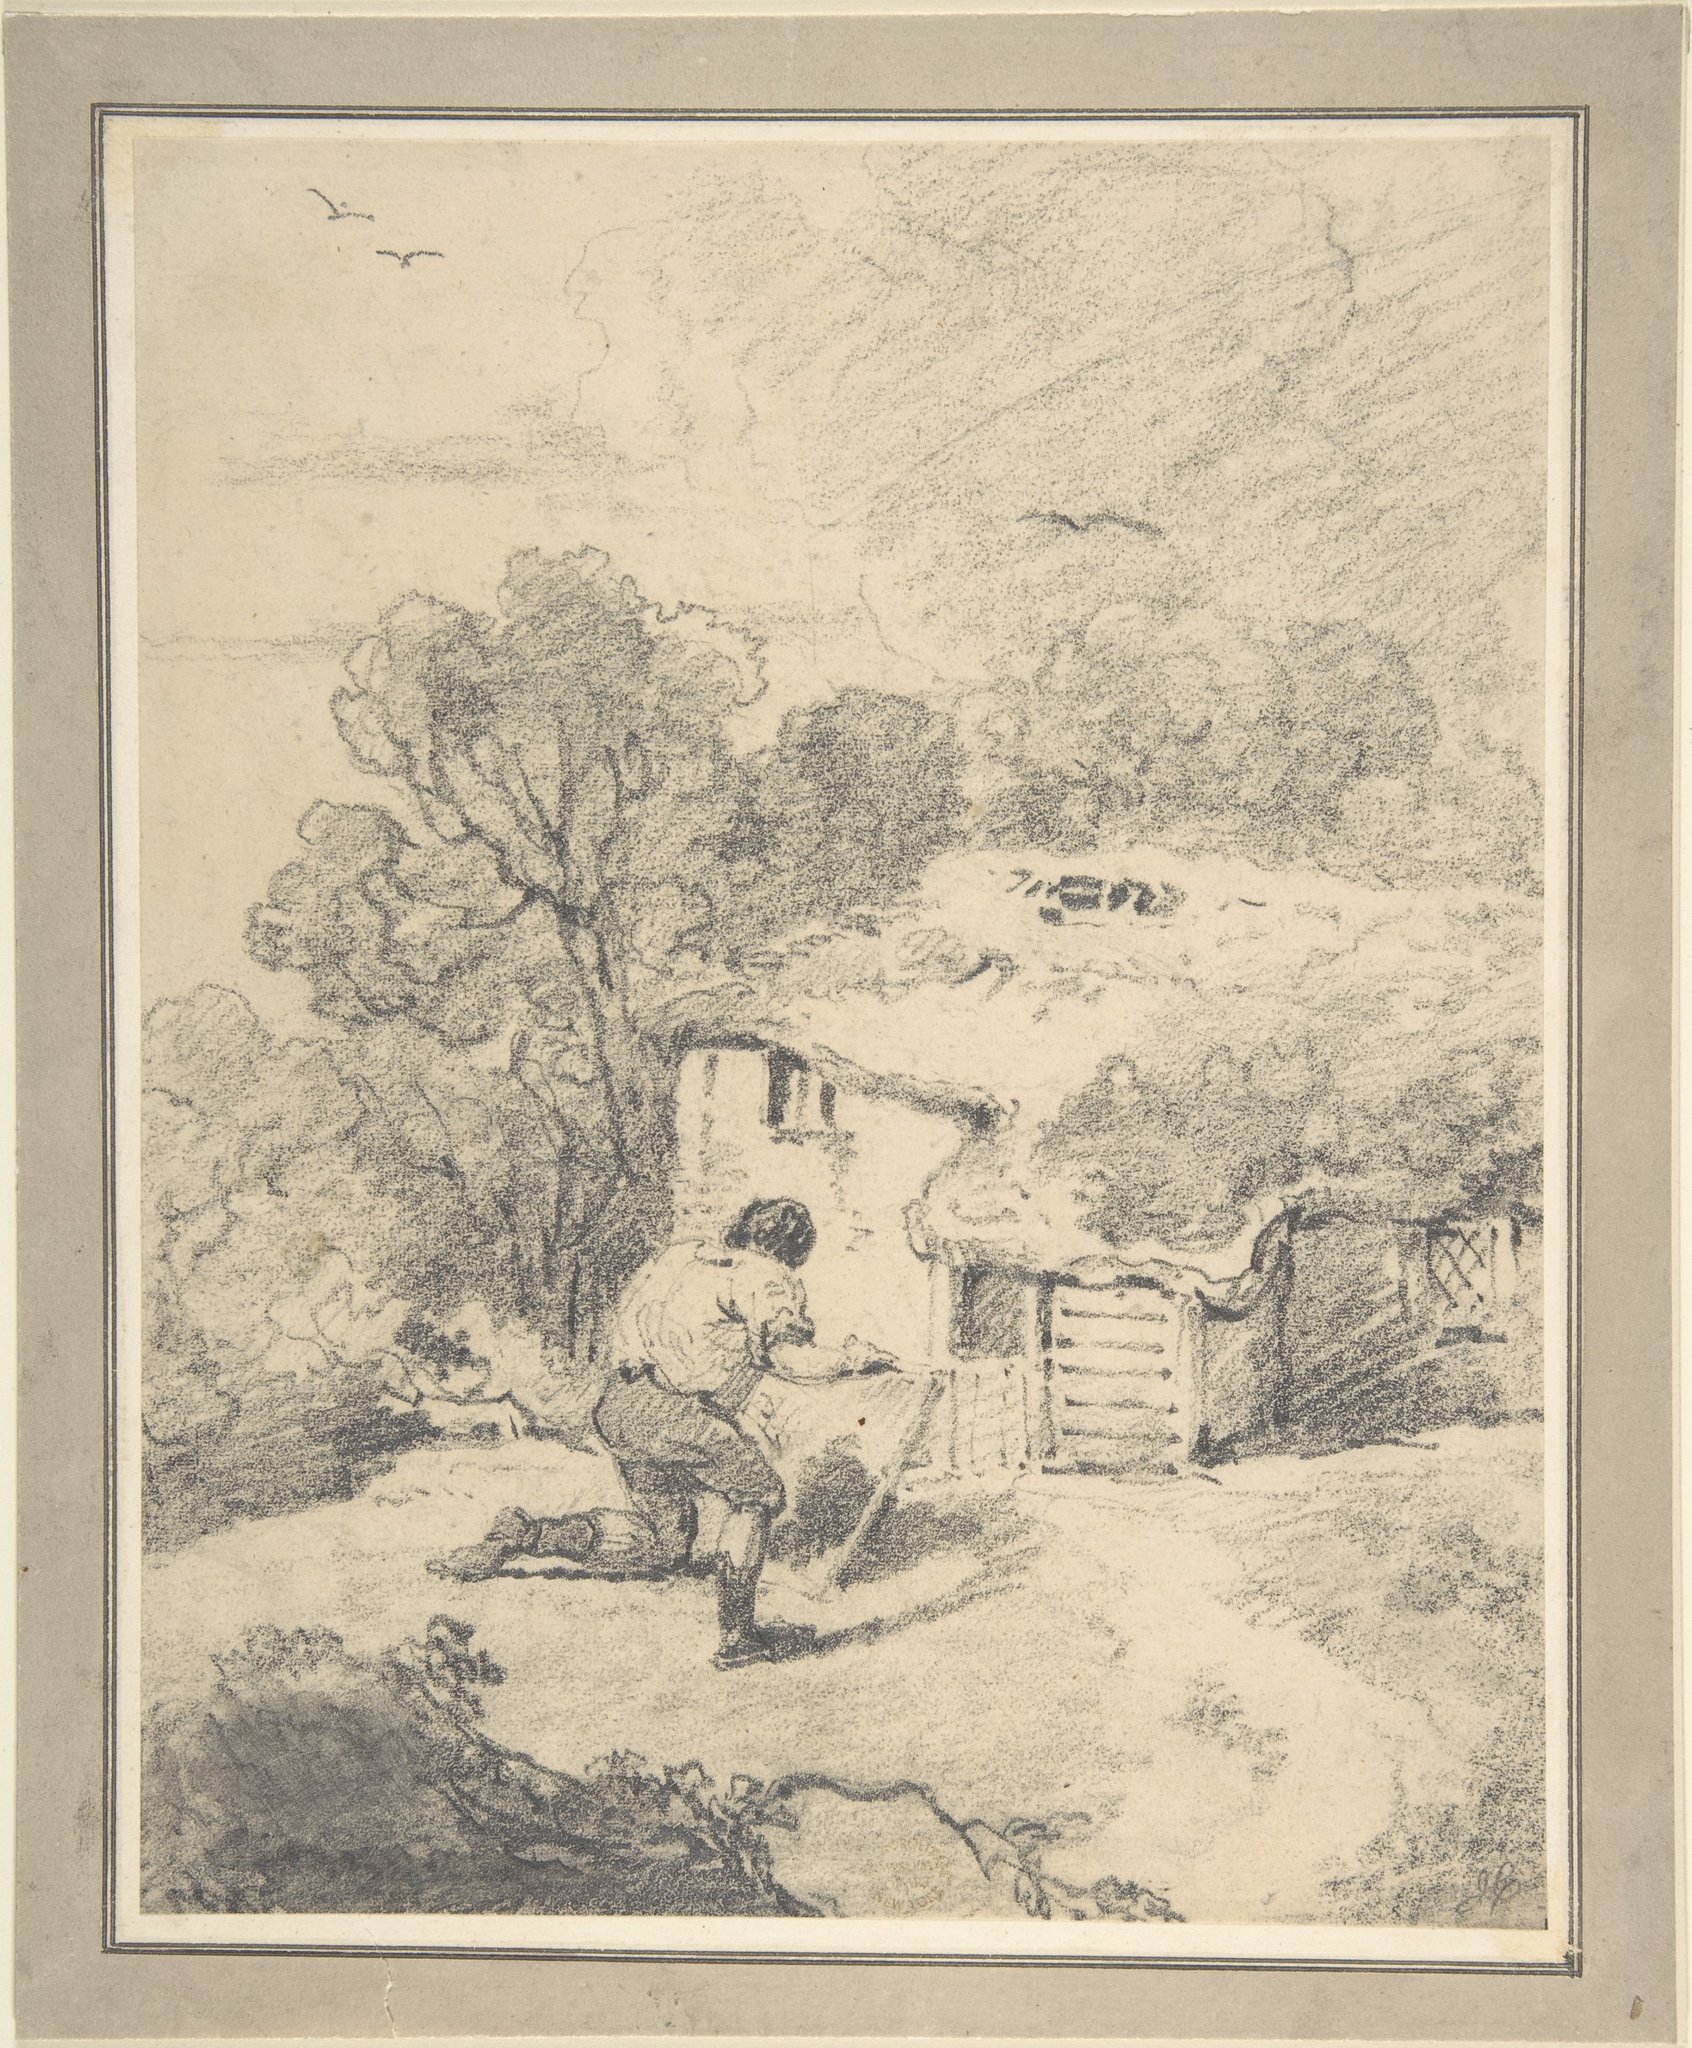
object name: drawing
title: Landscape with Figure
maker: george morland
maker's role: artist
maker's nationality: british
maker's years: 1763-1804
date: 1767-1833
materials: chalk, paper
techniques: wash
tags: human figures,houses,landscapes,trees